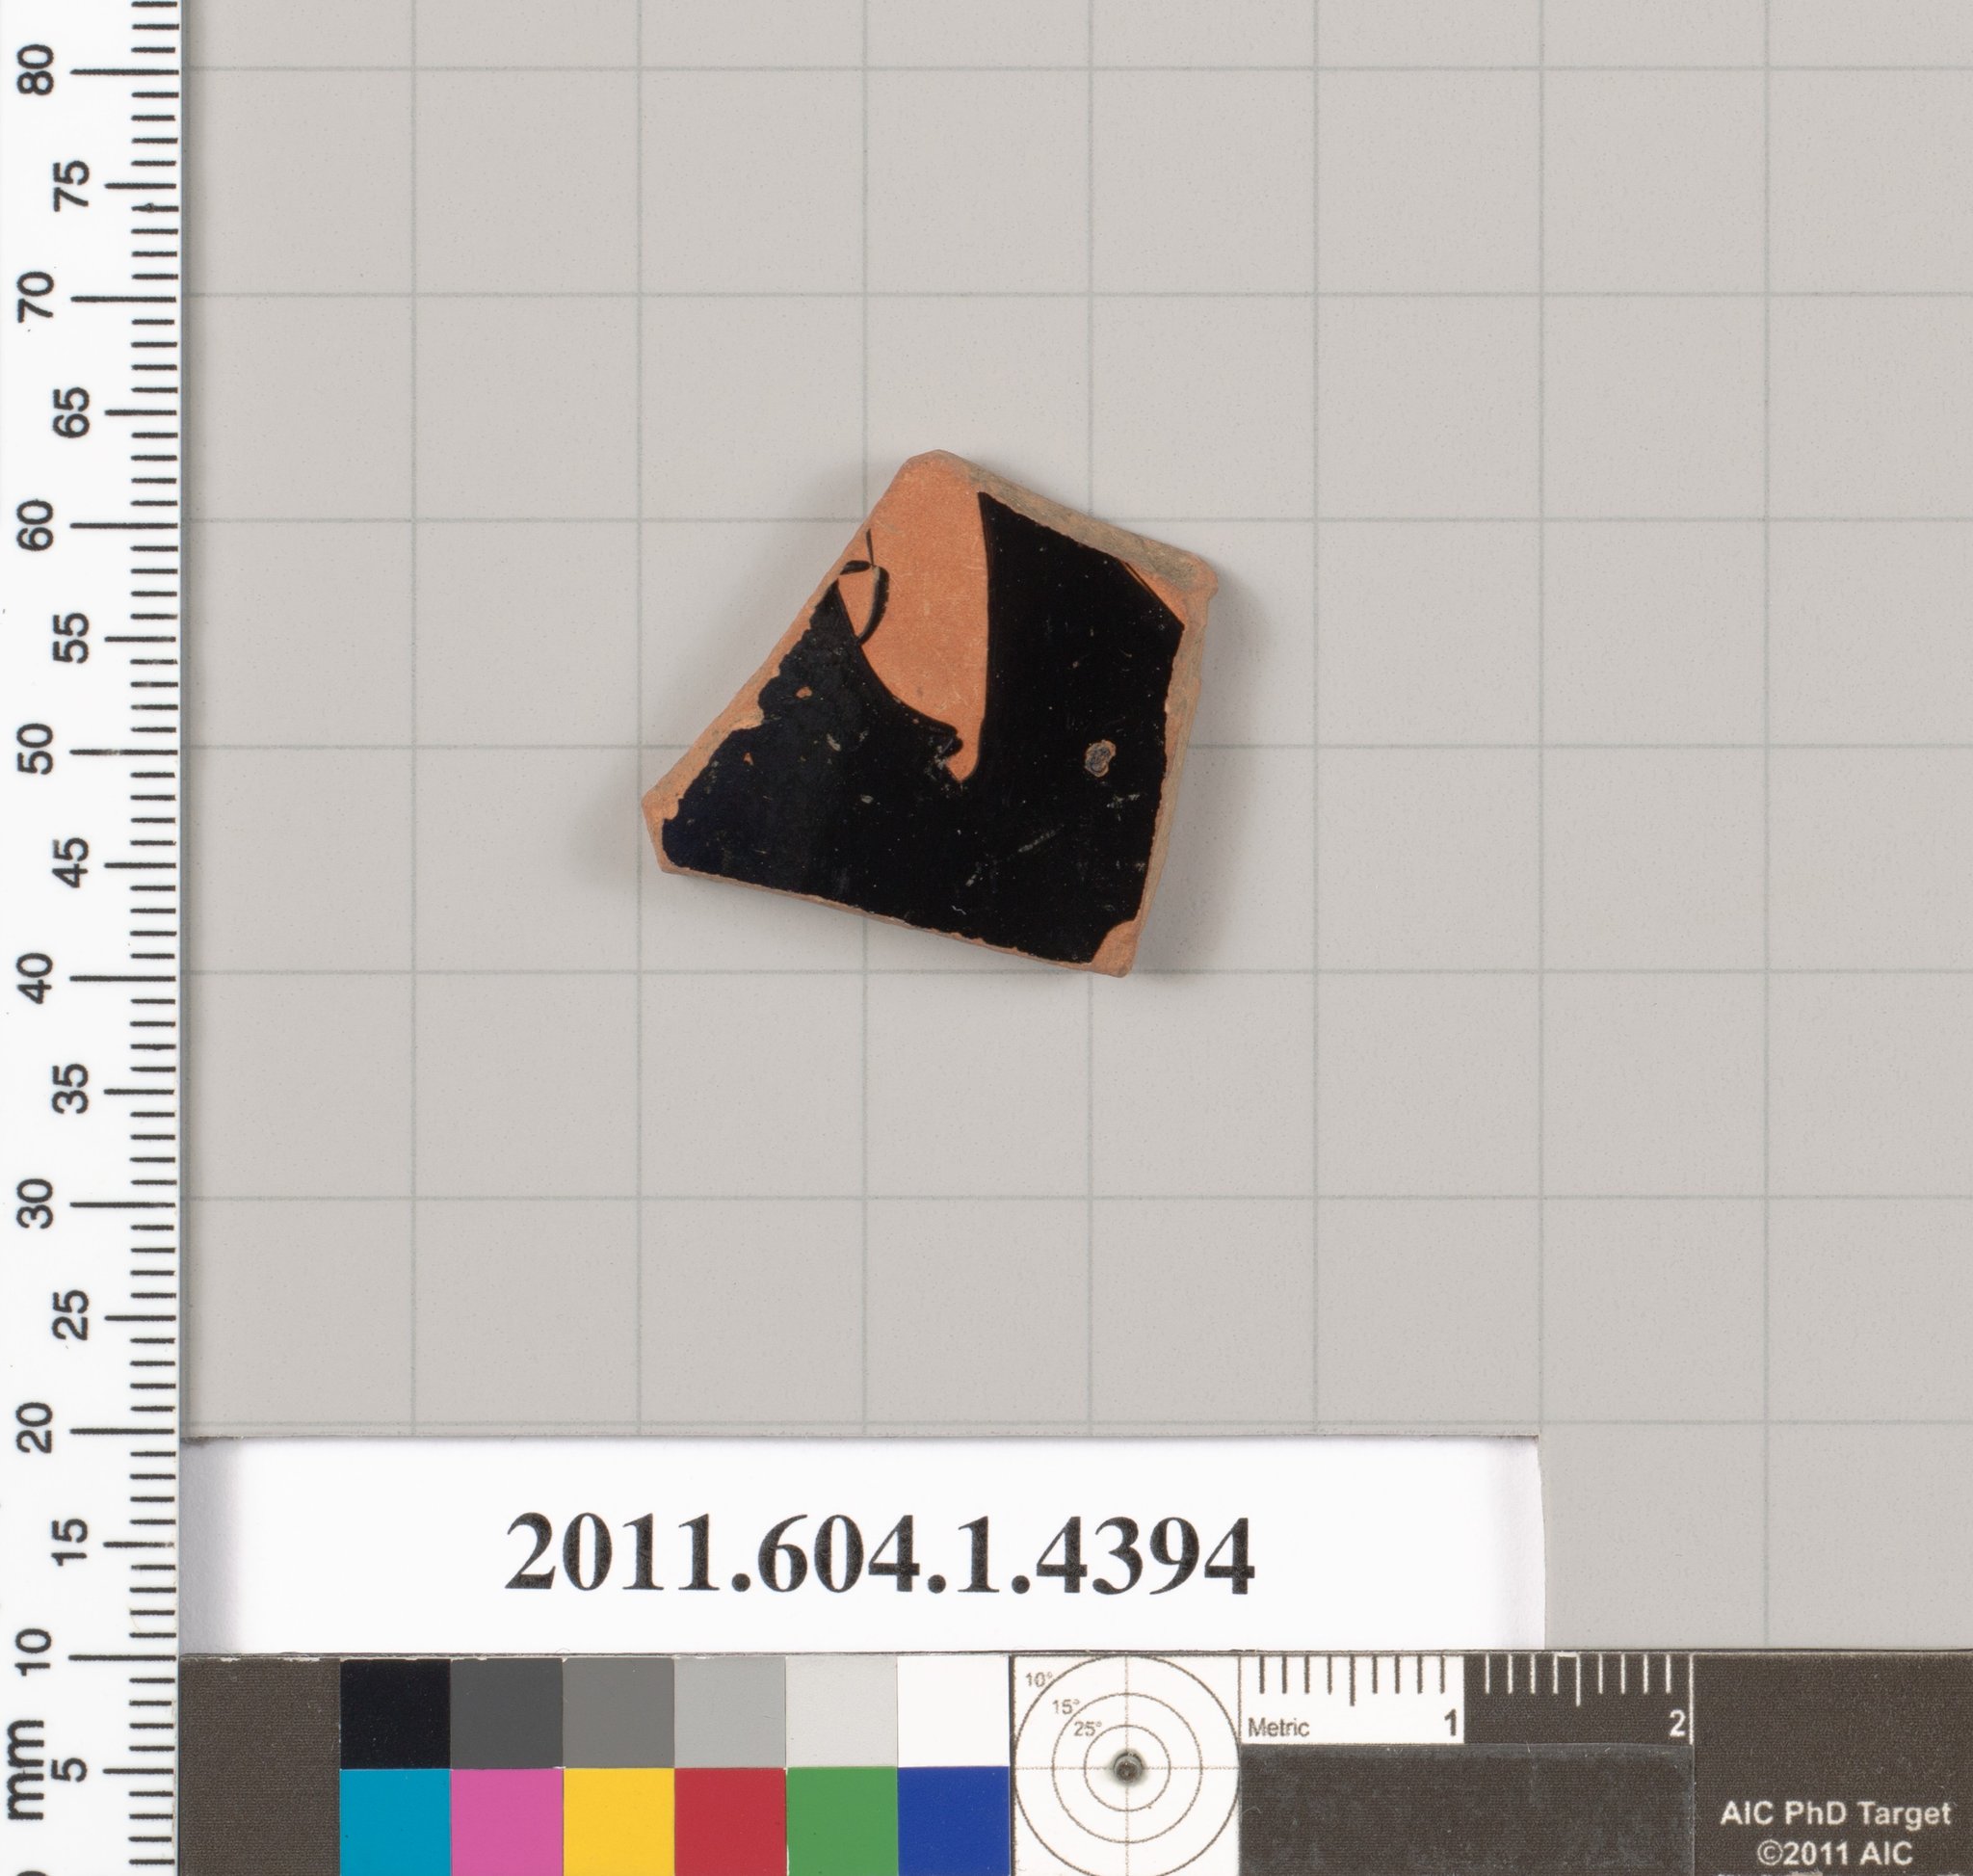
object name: kylix fragment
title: Terracotta fragment of a kylix (drinking cup)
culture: greek, attic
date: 490-470 BCE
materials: terracotta